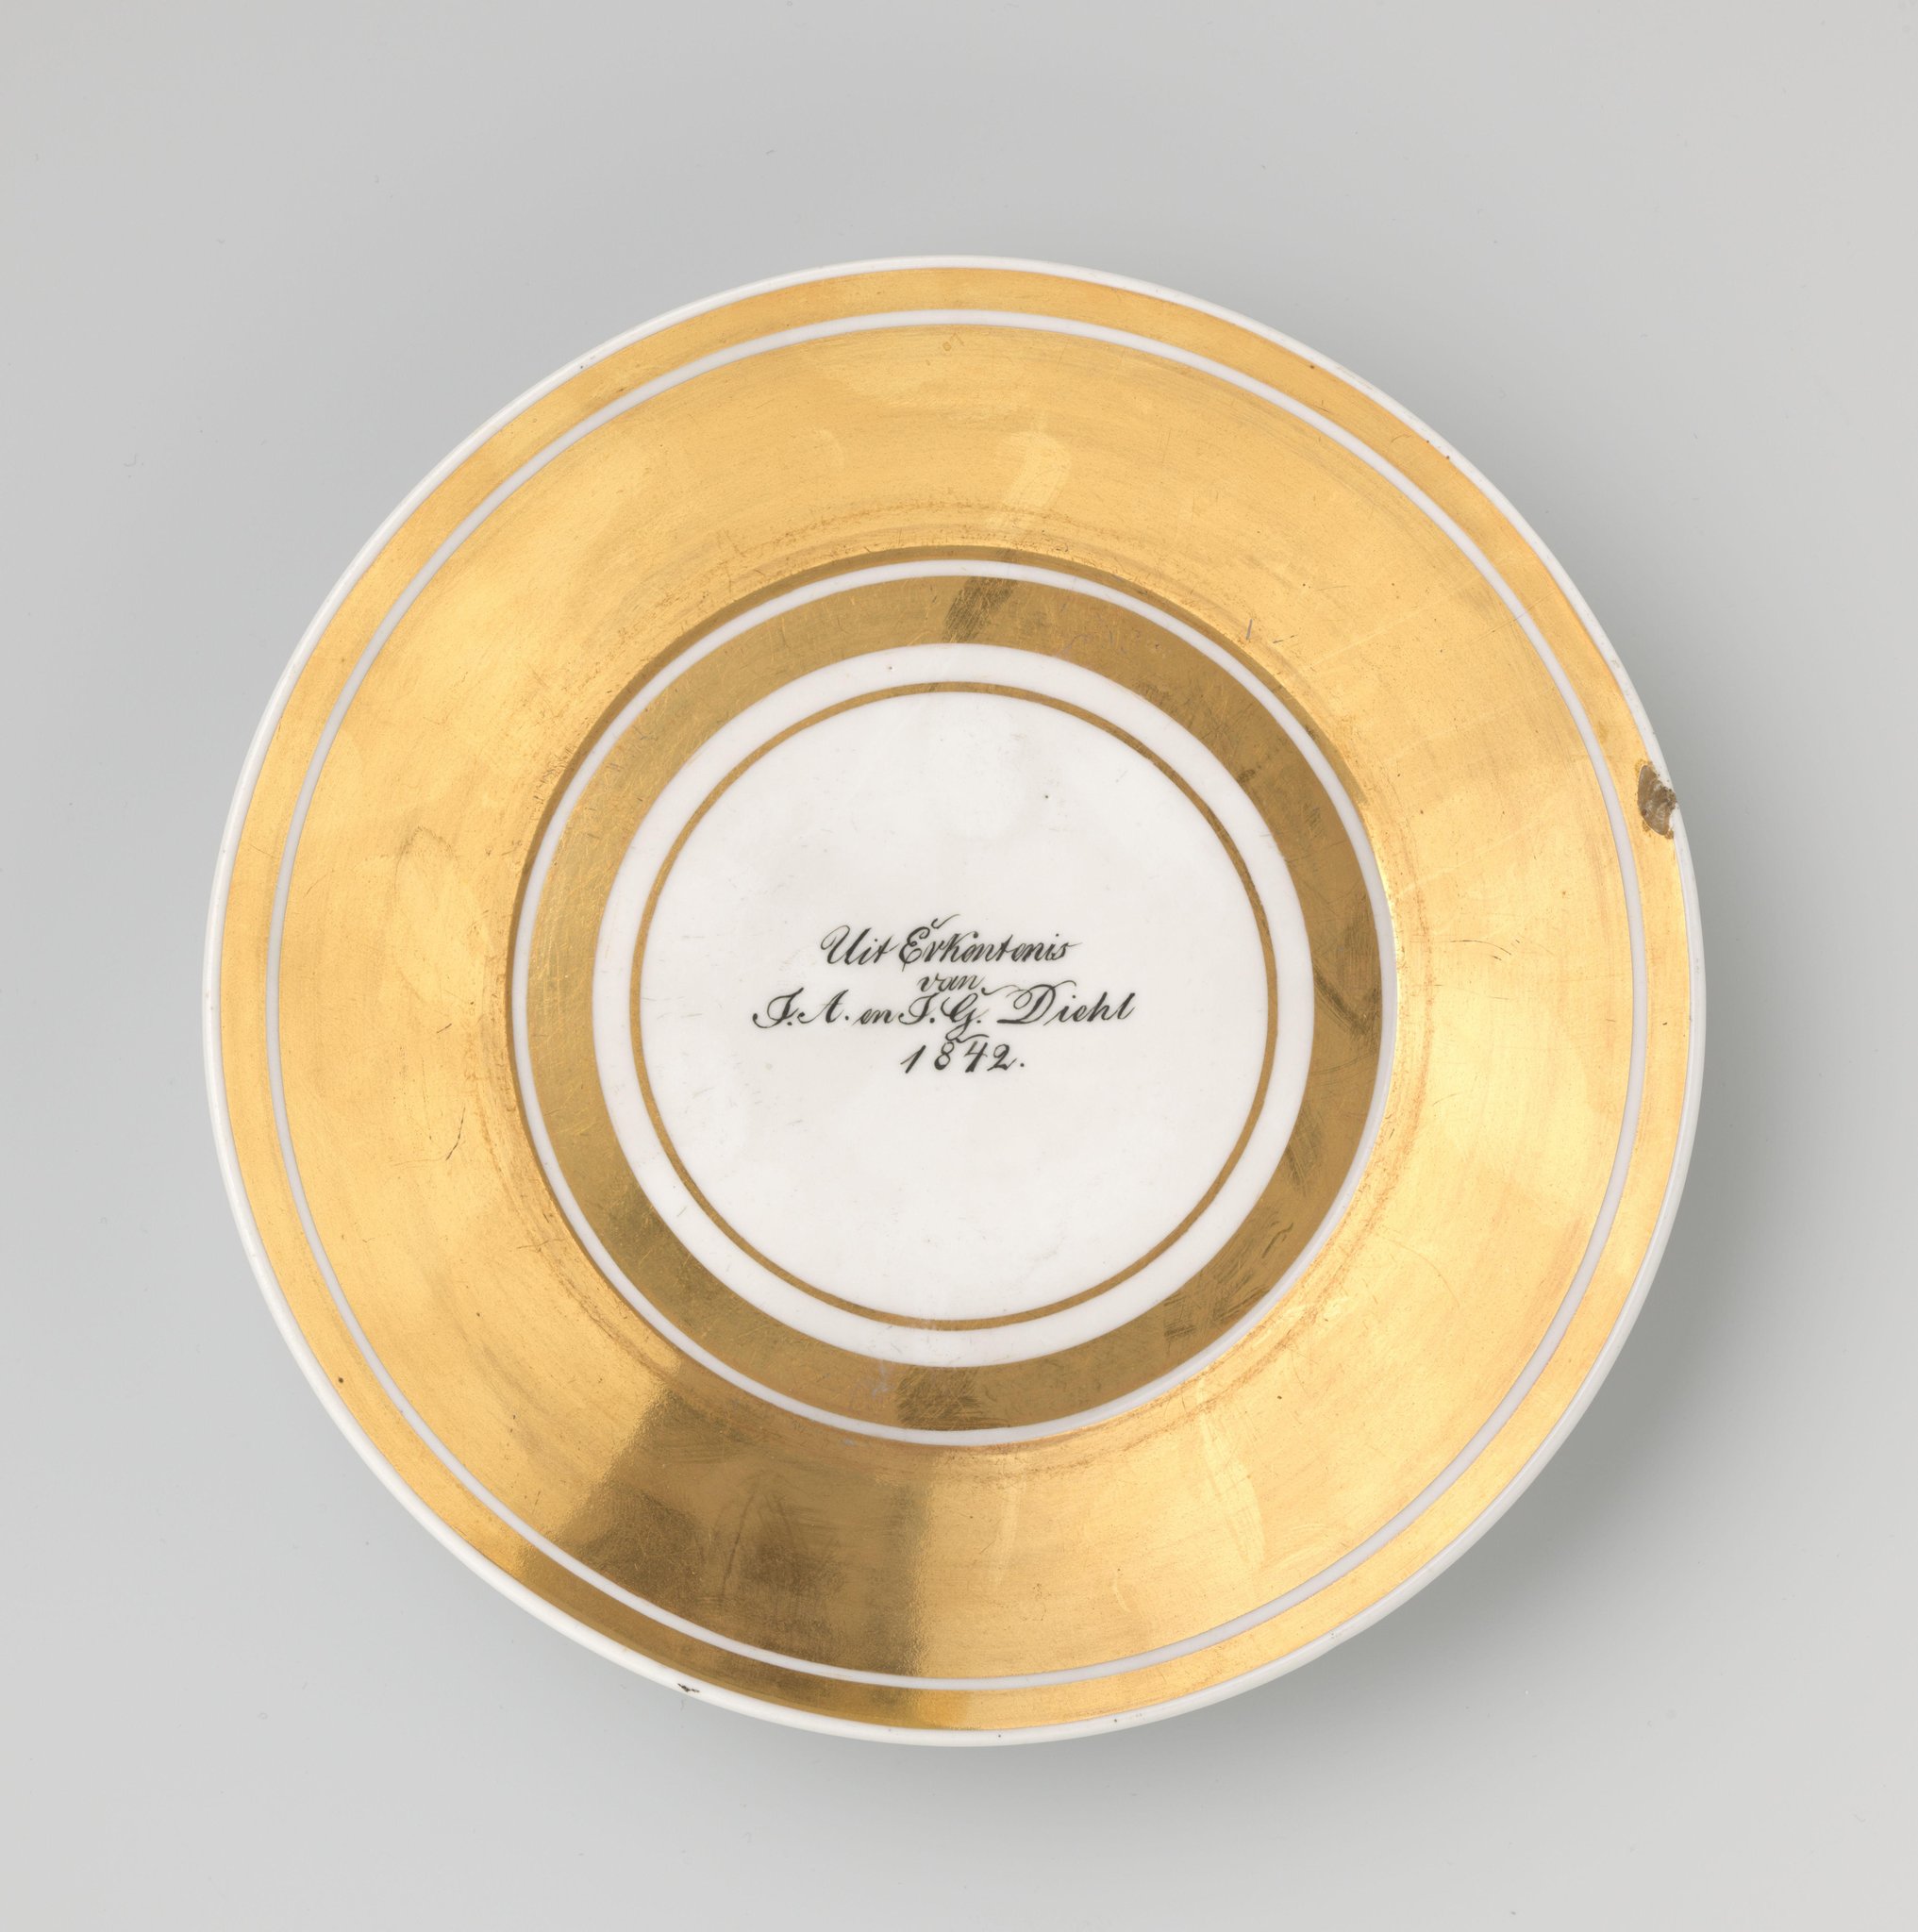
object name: platter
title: Saucer with an inscription and date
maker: Anonymous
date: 1842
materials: glaze, gold, paint, porcelain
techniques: firing, forming, gilding, relief, turning, vitrification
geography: europe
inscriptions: mark: ‘zwaard of f’, inscription: ‘UIT ERKENTENIS VAN J.A en J.G DIEHL 1842’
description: Schotel van porselein, beschilderd in zwart en goud. De voorzijde van de schotel is grotendeels bedekt met gouden banden. Op het plat is een medaillon uitgespaard met daarin het opschrift 'UIT ERKENTENIS VAN J.A en J.G DIEHL 1842'. Gemerkt op de onderzijde met een zwaard of f.